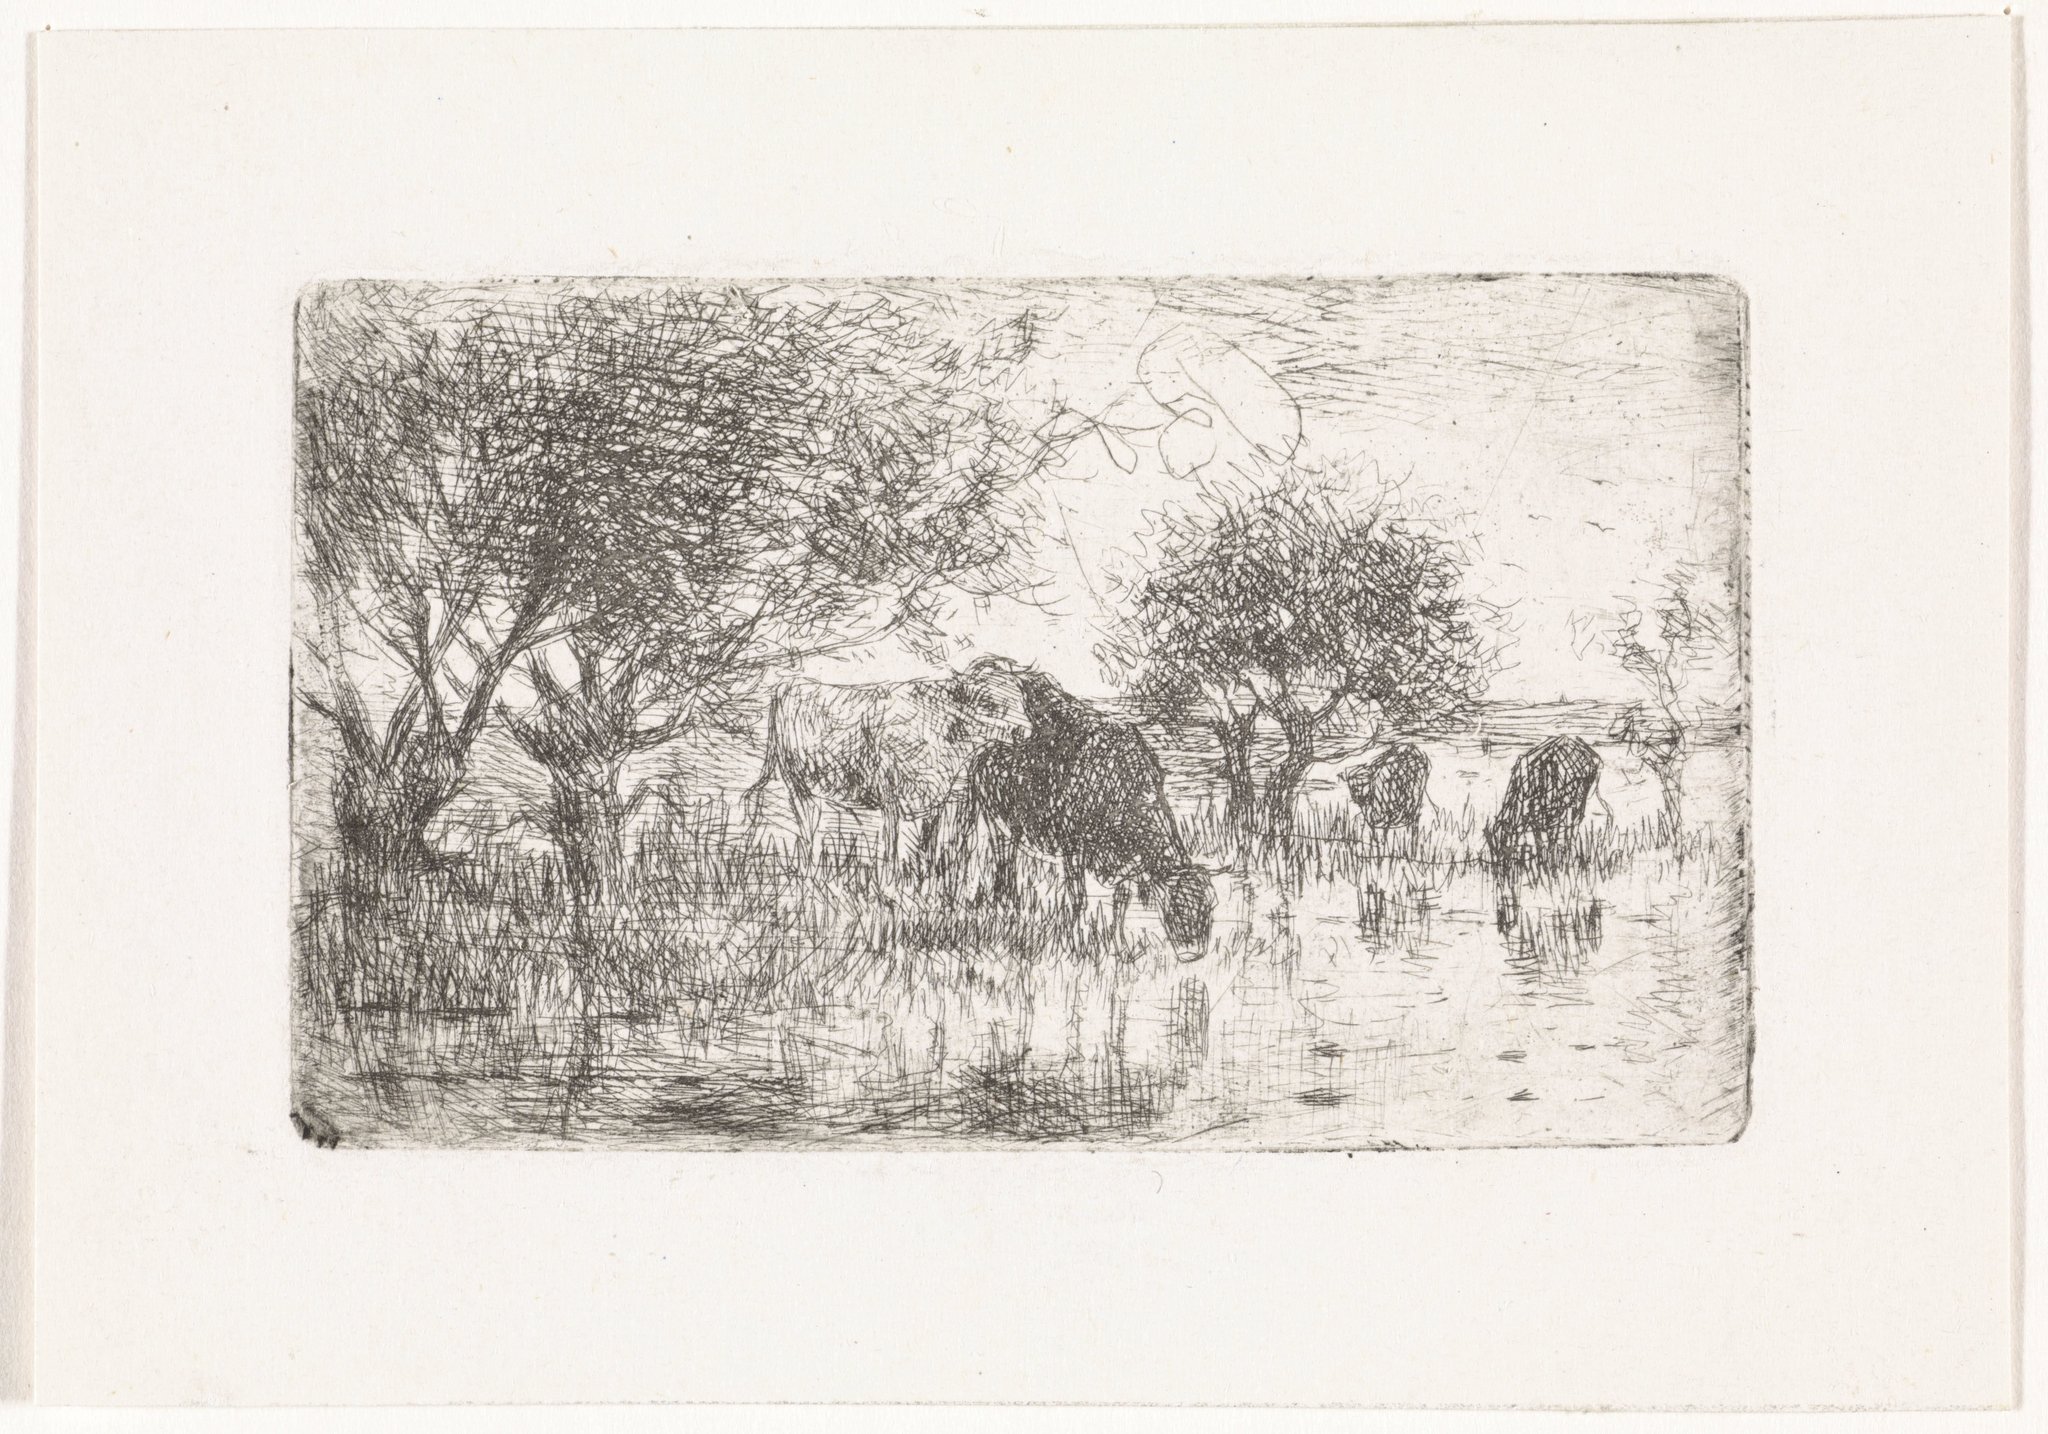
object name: print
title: Landschap met koeien bij een water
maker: jan vrolijk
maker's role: draughtsman, painter, print maker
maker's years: 1846-1894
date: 1860-1894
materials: paper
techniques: etching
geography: the hague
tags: cow, river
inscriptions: collector's mark: Lugt 2228